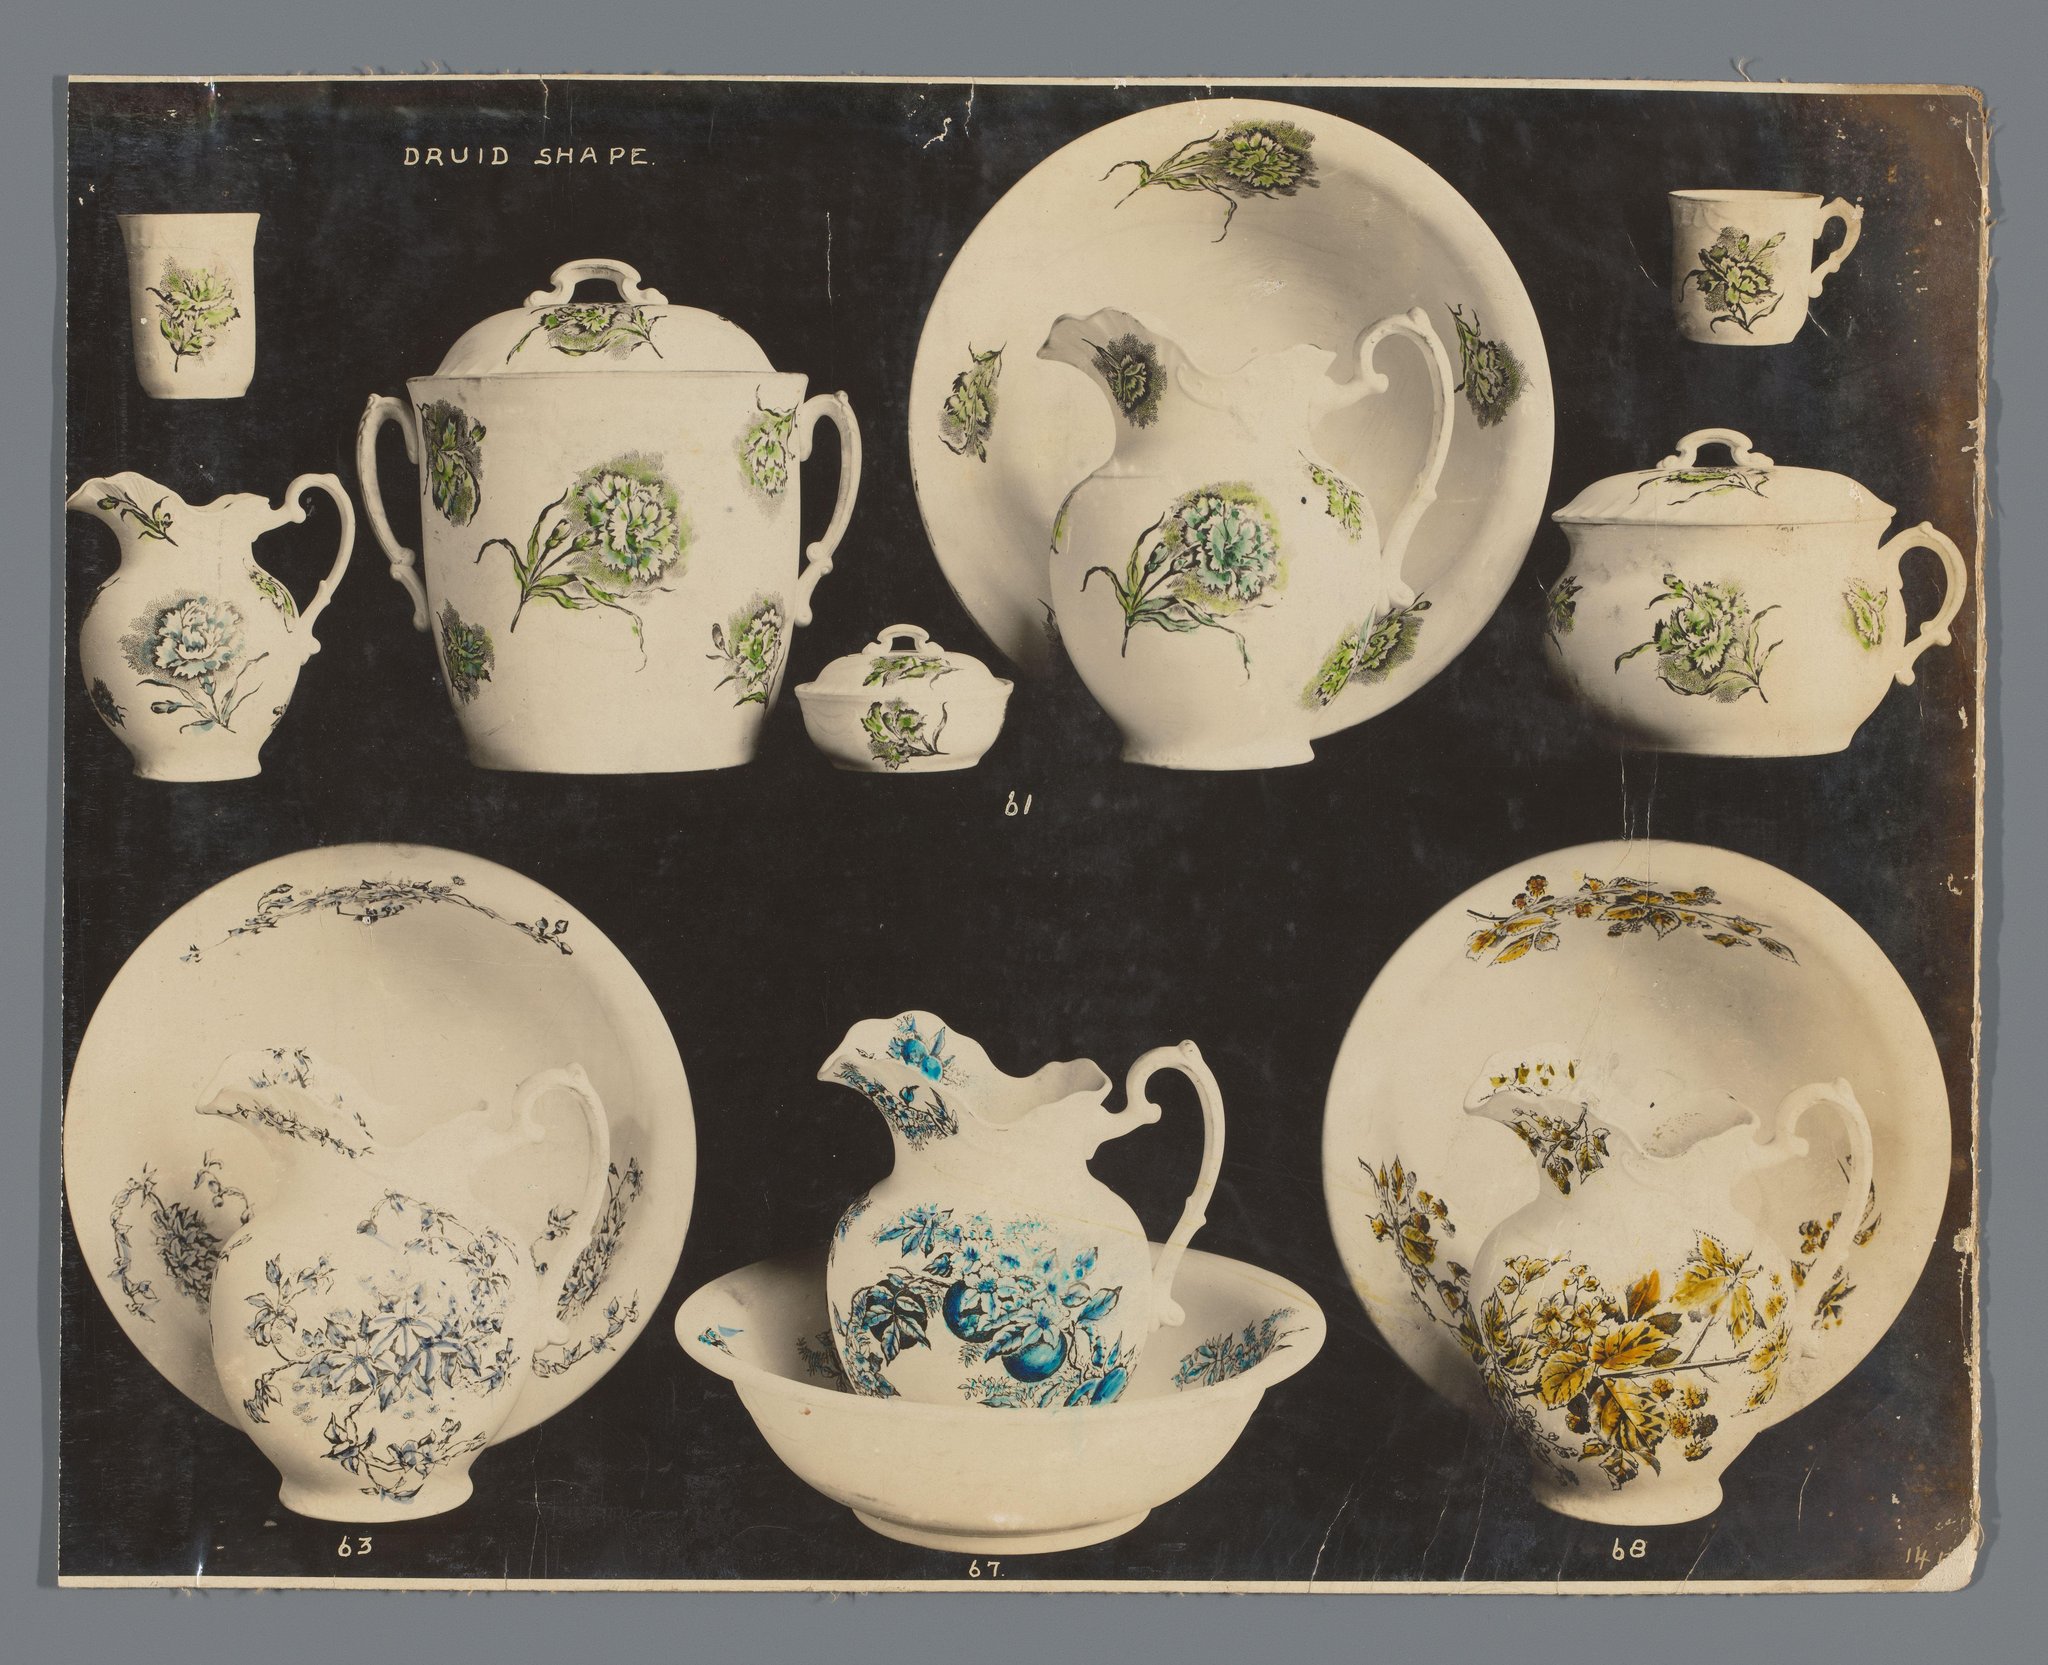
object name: photograph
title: Reclamefoto met serviezen en keukengerei van de firma C. Read & Co., Baltimore, Maryland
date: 1920-1930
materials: paper, textile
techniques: photography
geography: united states